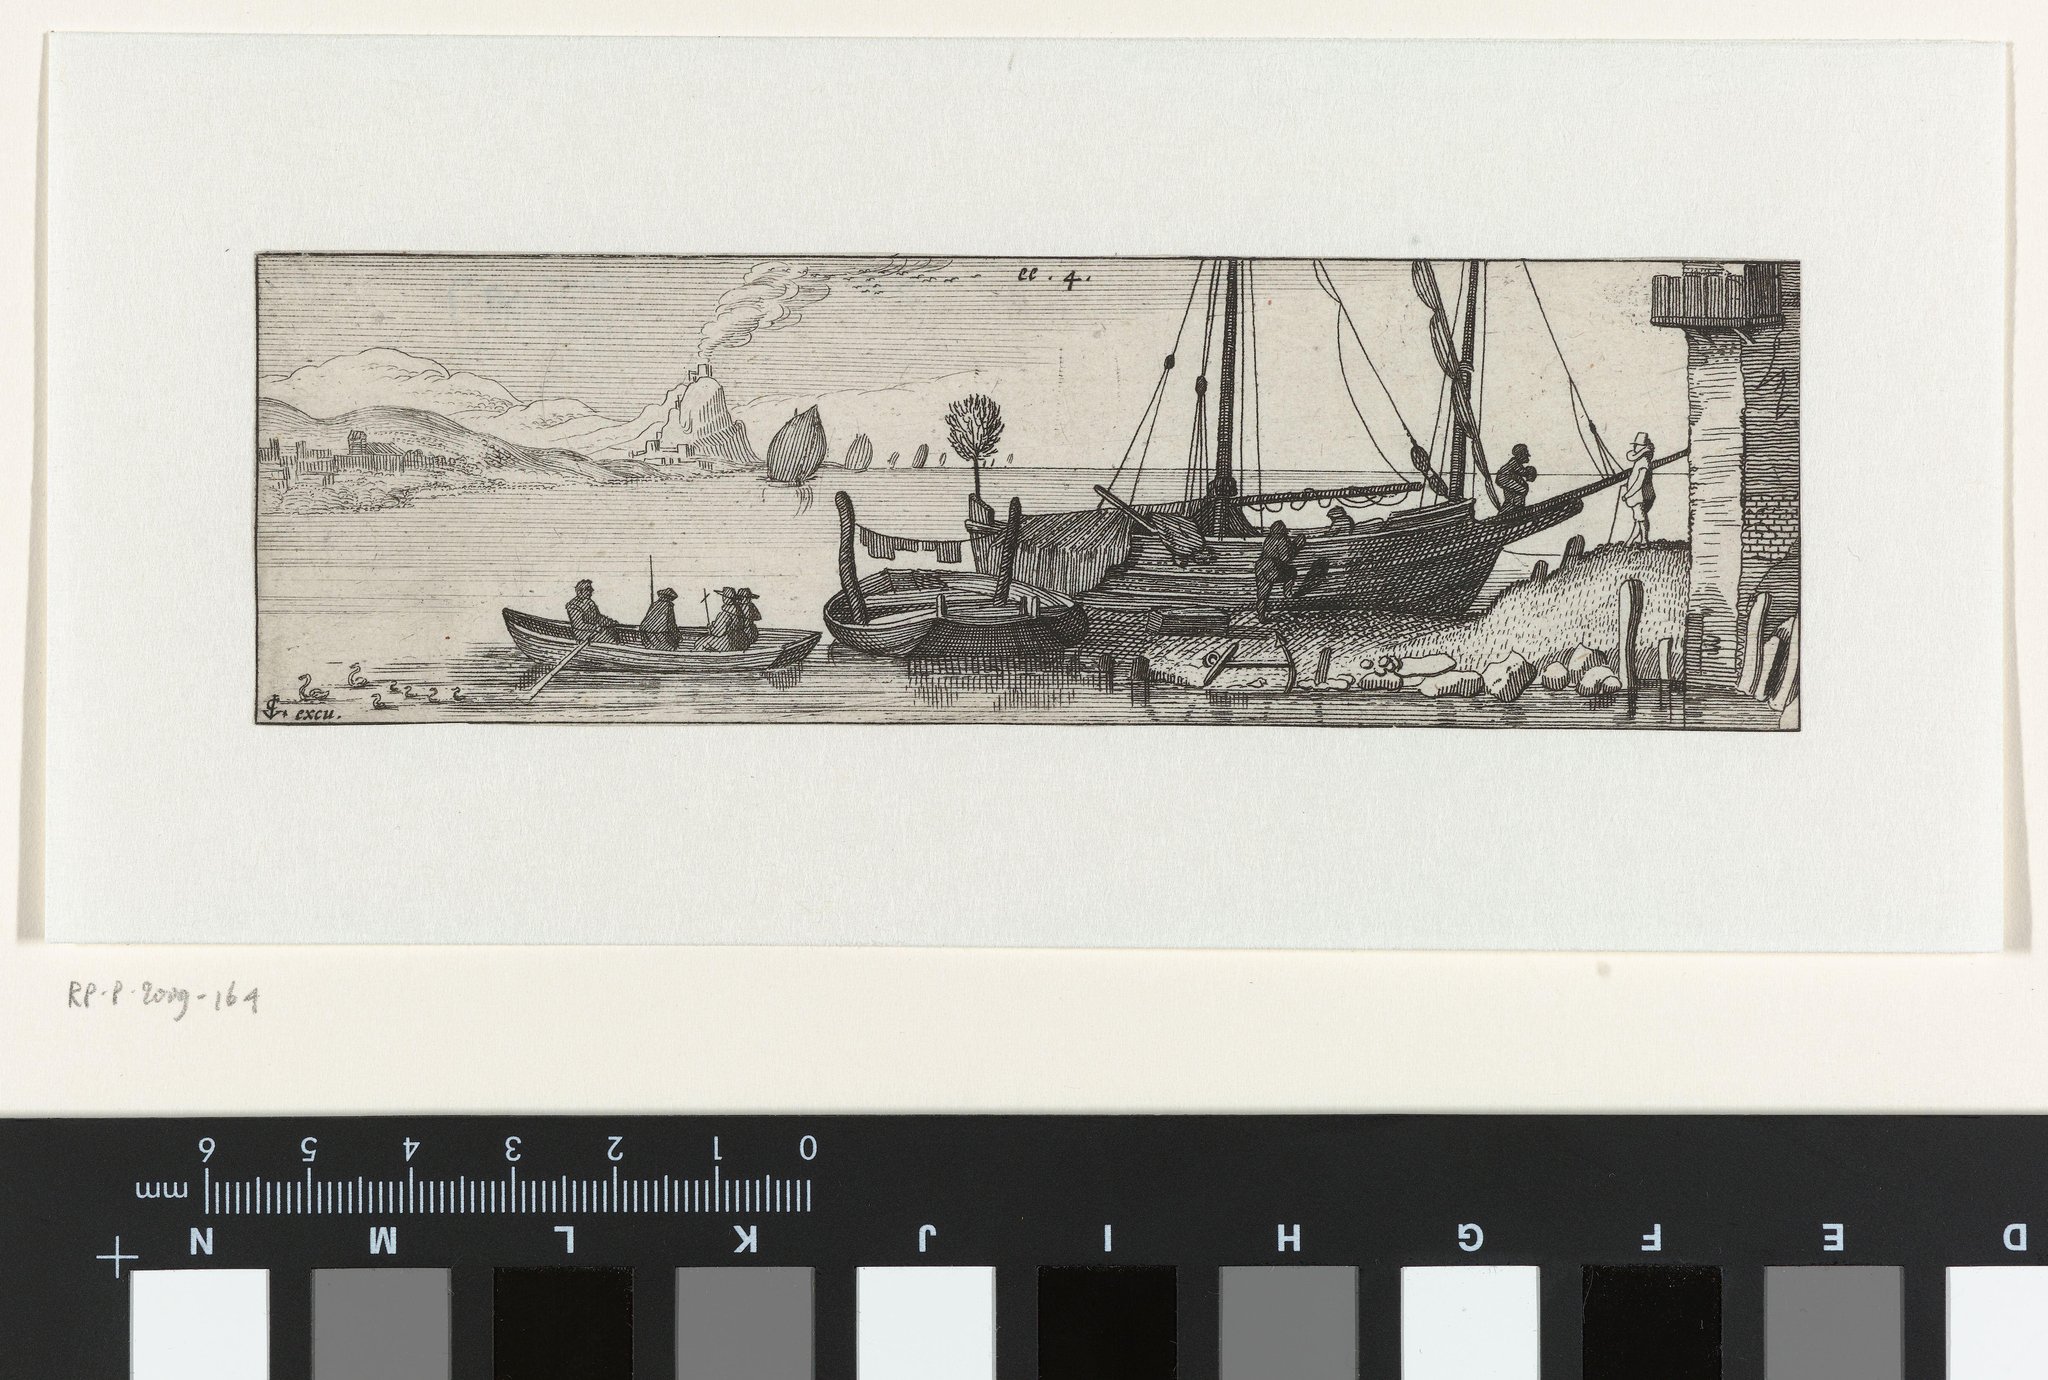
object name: print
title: Kustgezicht met aangemeerde boten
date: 1620-1630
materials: paper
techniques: engraving, etching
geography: low countries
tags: sailing-ship, sailing-boat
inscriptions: collector's mark: Lugt 2228, collector's mark: Lugt 2760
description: Achtste prent uit een serie van negentien met gezichten op de omgeving van Amsterdam. Landschap met twee aangemeerde boten. Een bootje met daarin vier figuren vaart weg.